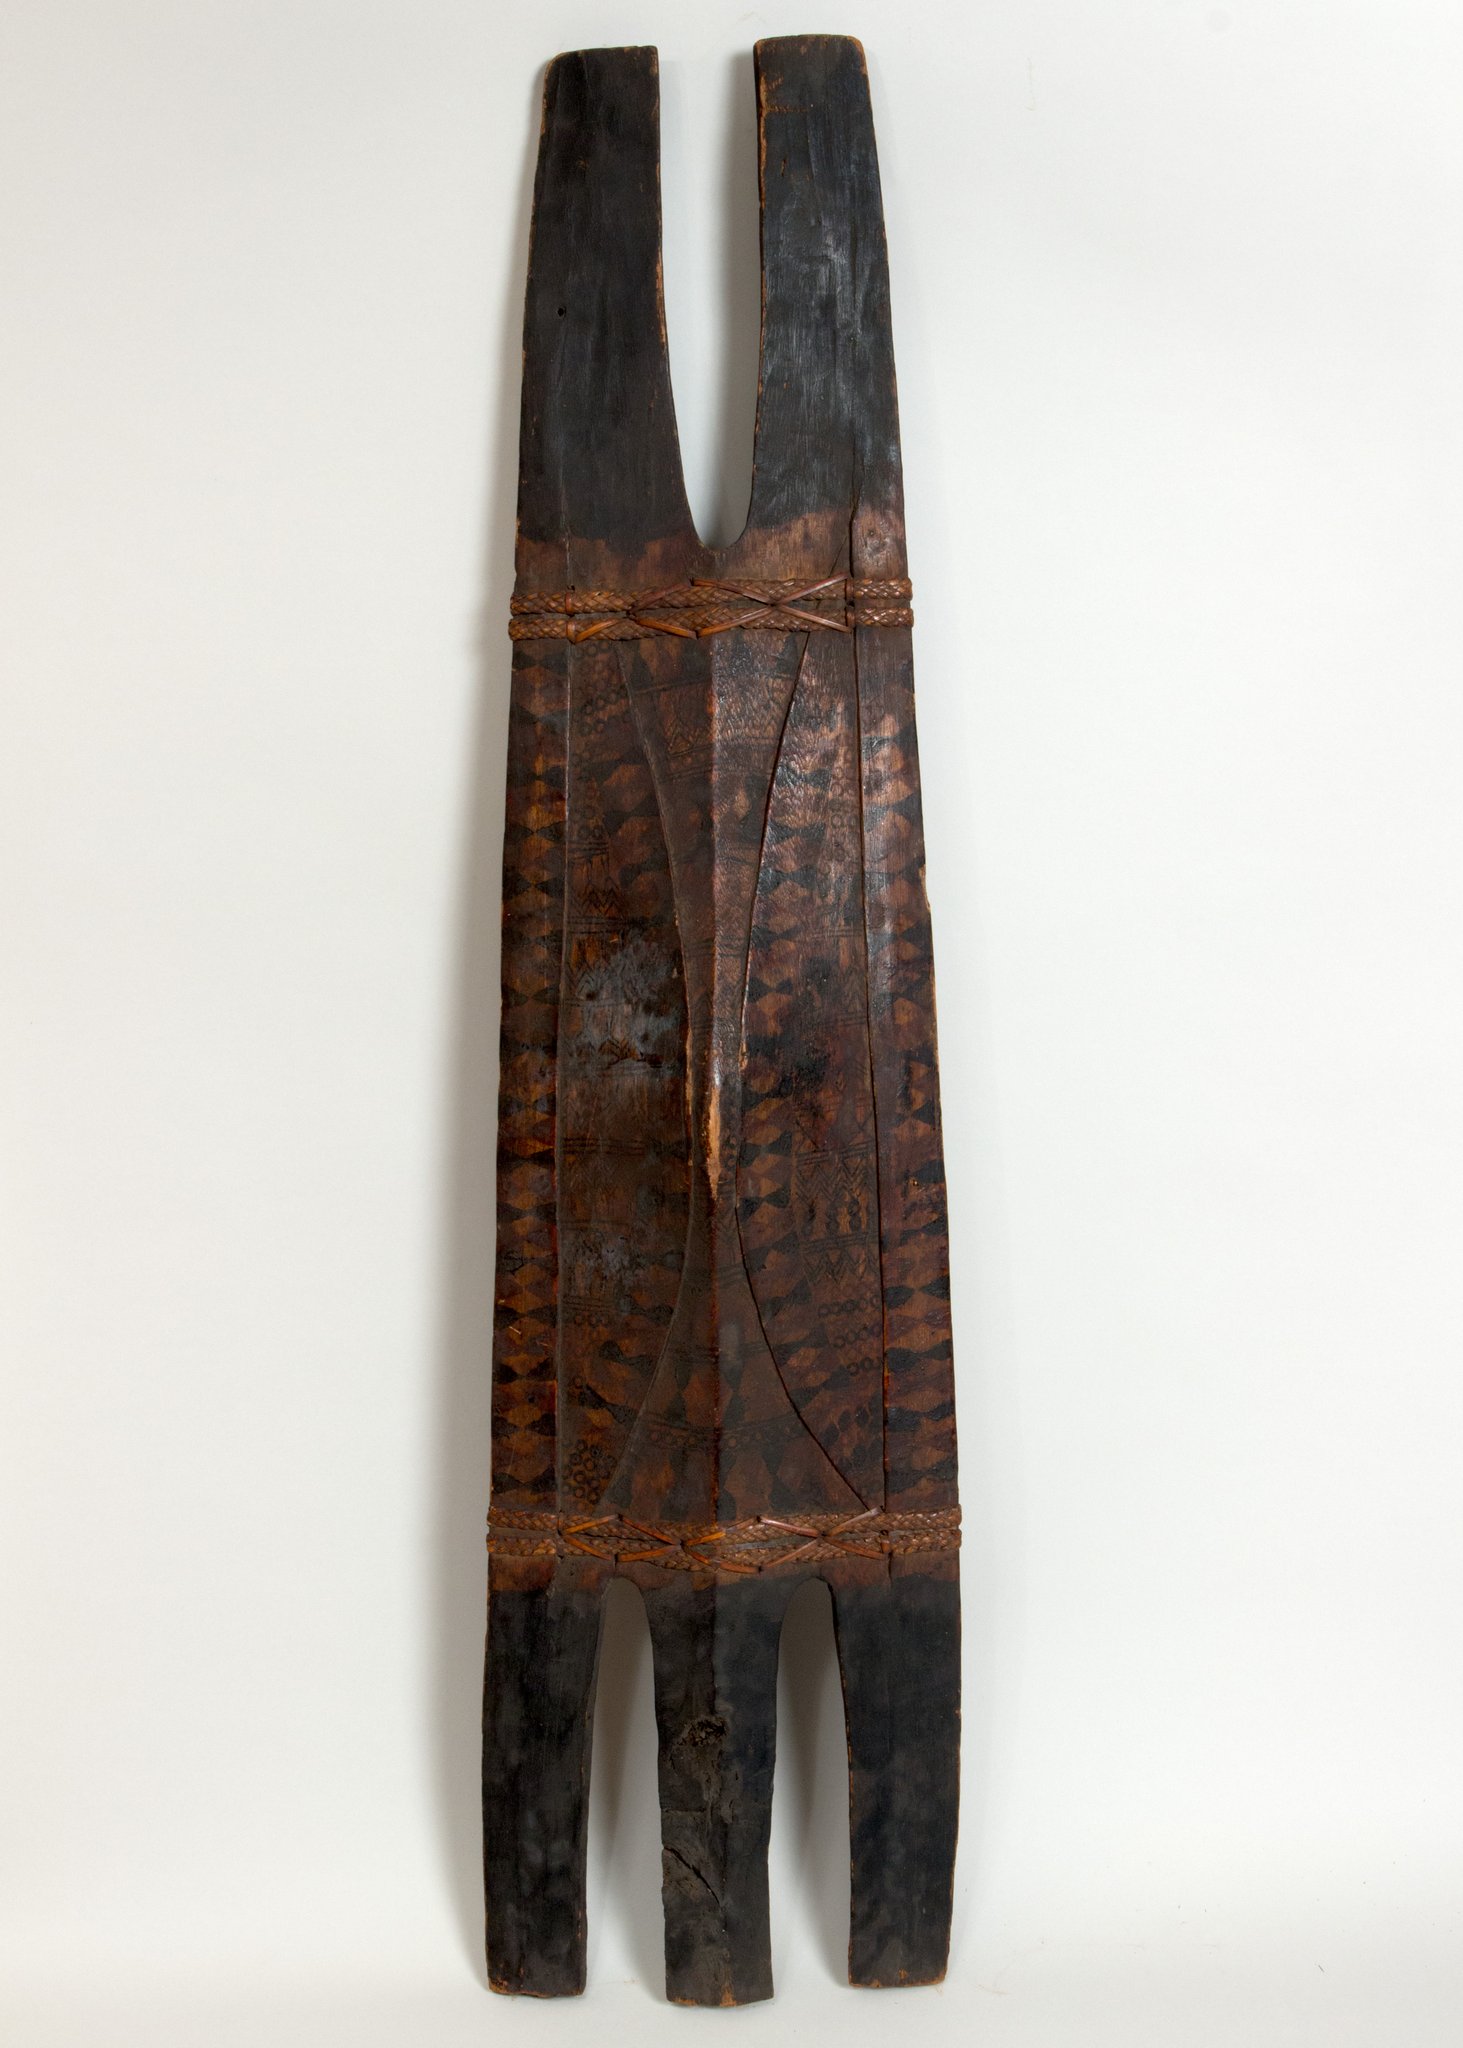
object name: shield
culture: philippine or igorot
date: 1701-1900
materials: wood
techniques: polychromy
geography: philippines